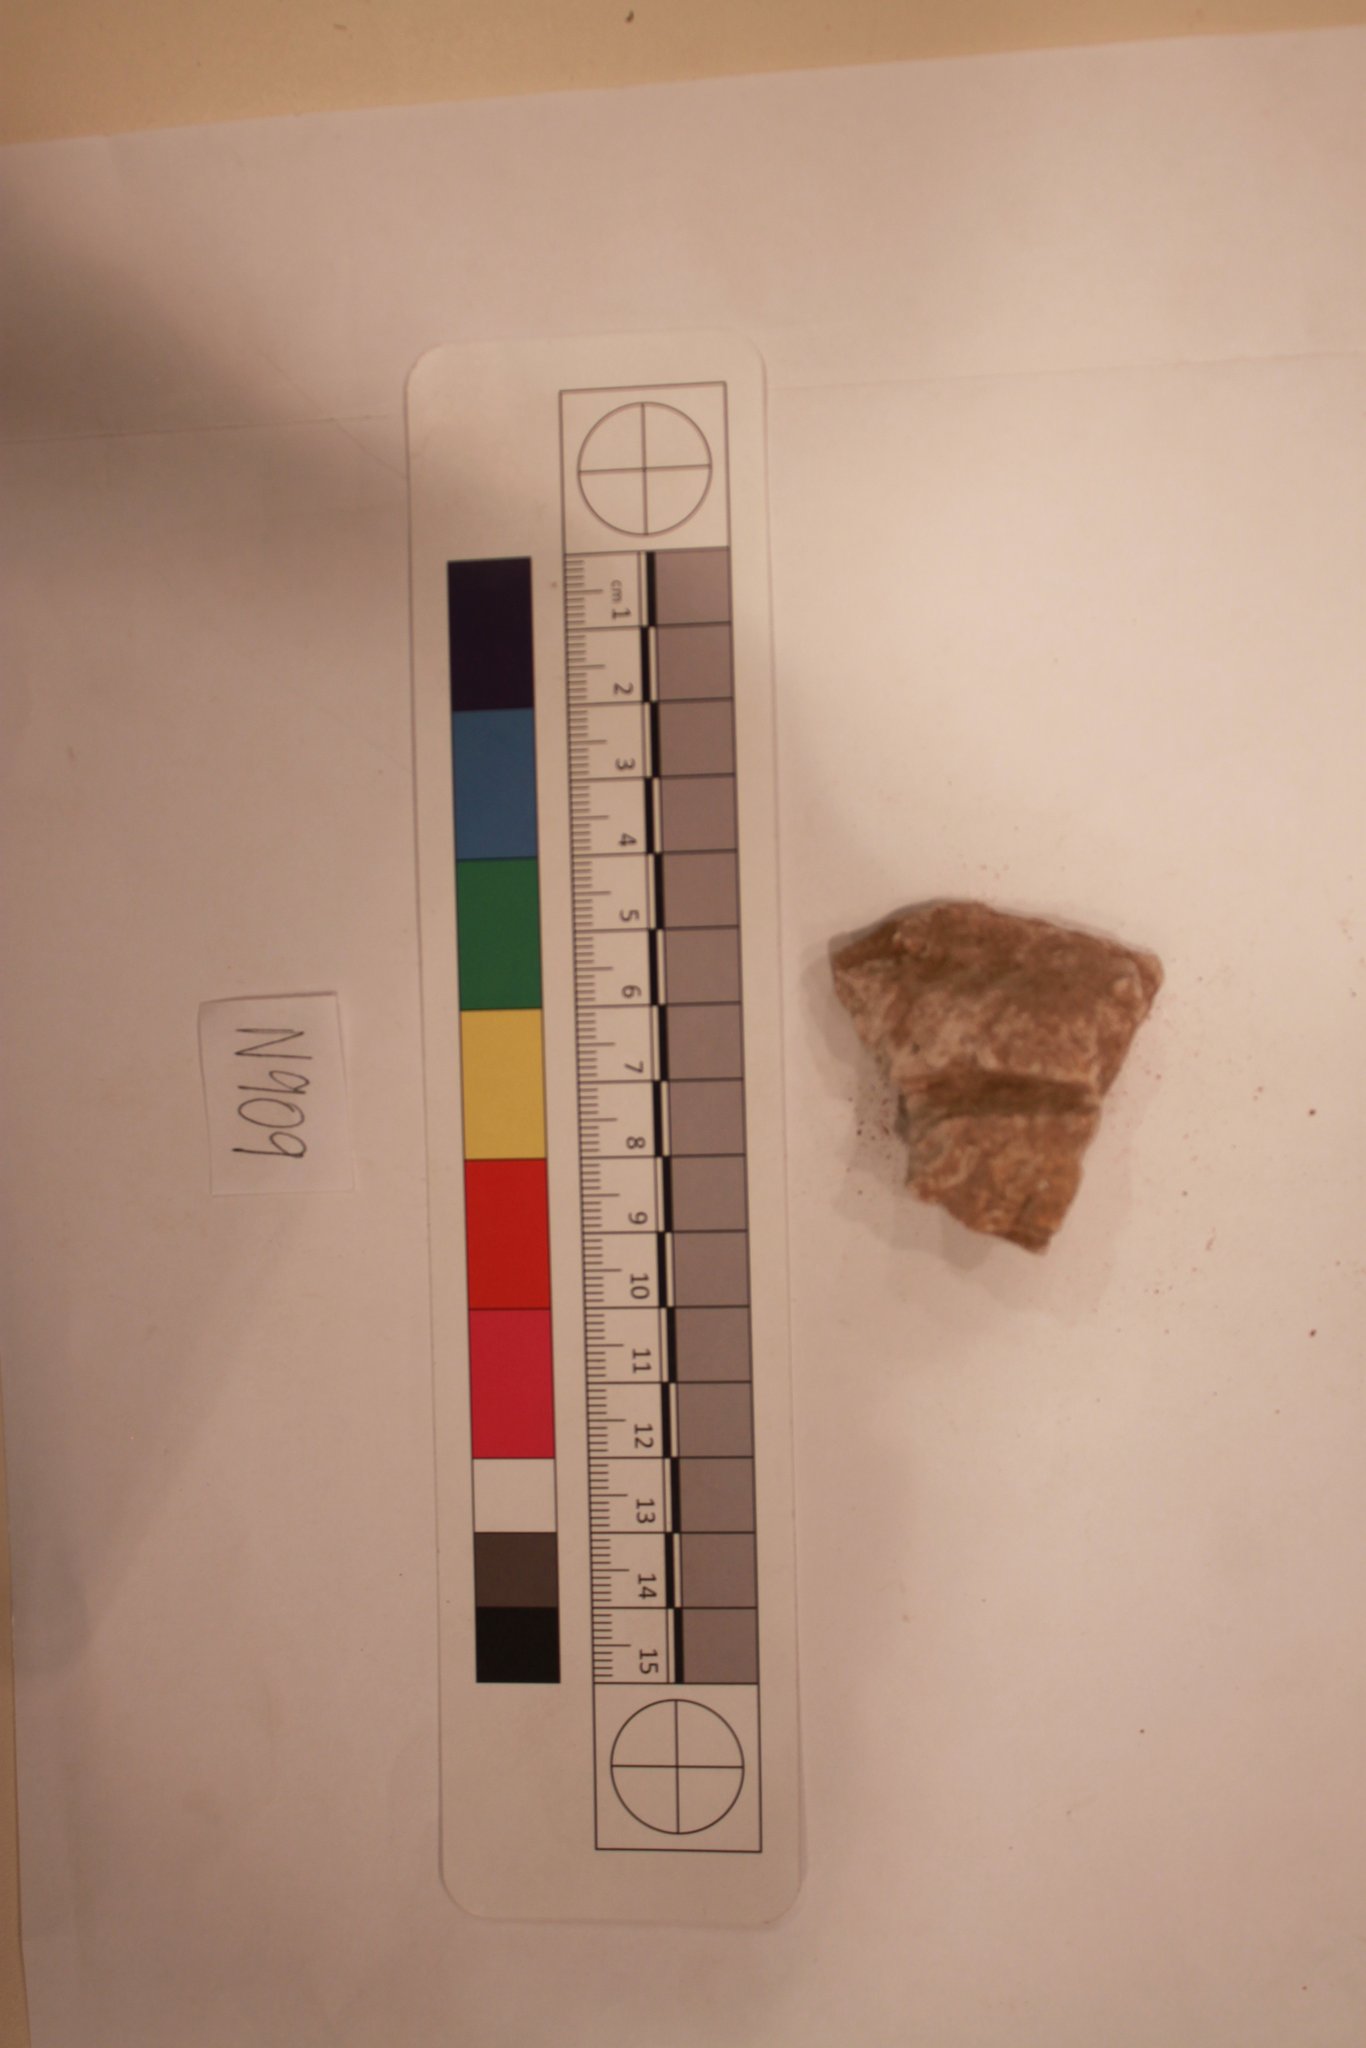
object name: fragment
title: Stucco Fragment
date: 701-1200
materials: plaster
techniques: carving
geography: iran